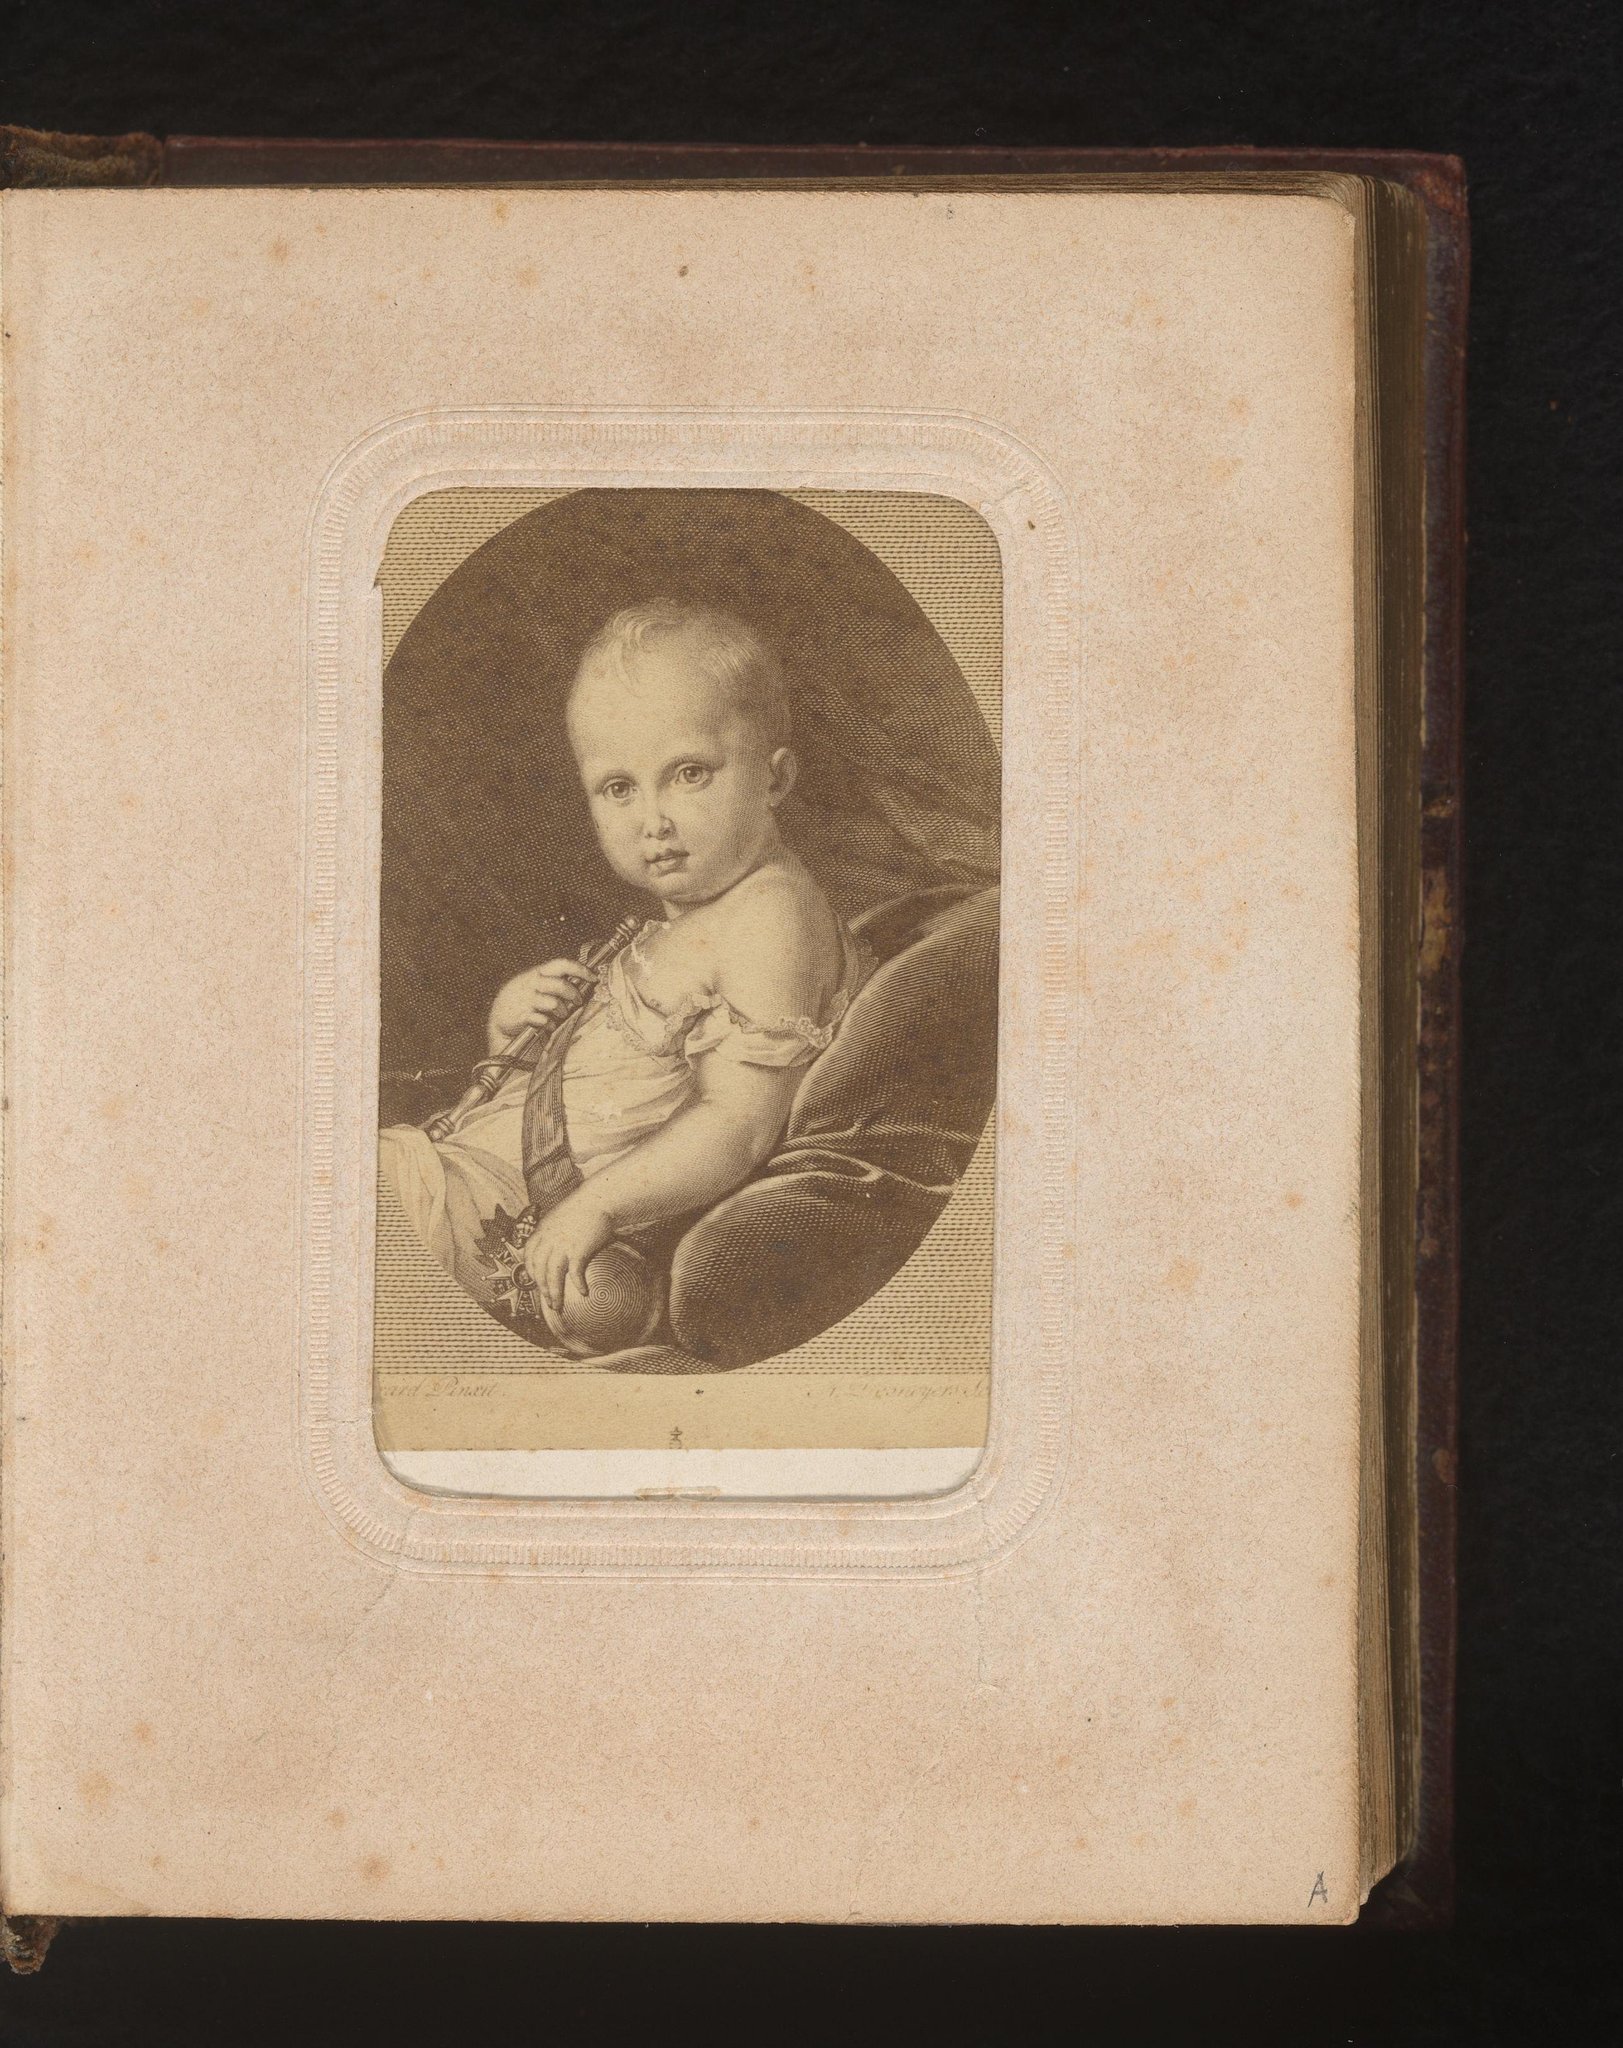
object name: carte de visite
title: Fotoreproductie van prent van een portret van een baby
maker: mi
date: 1860-1900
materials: cardboard, photographic support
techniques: albumen print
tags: historical persons, infant, baby ~ the ages of man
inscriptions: annotation: ‘fam Mabbur[lh] 8 [..]/ [...]’, monogram: ‘MI’